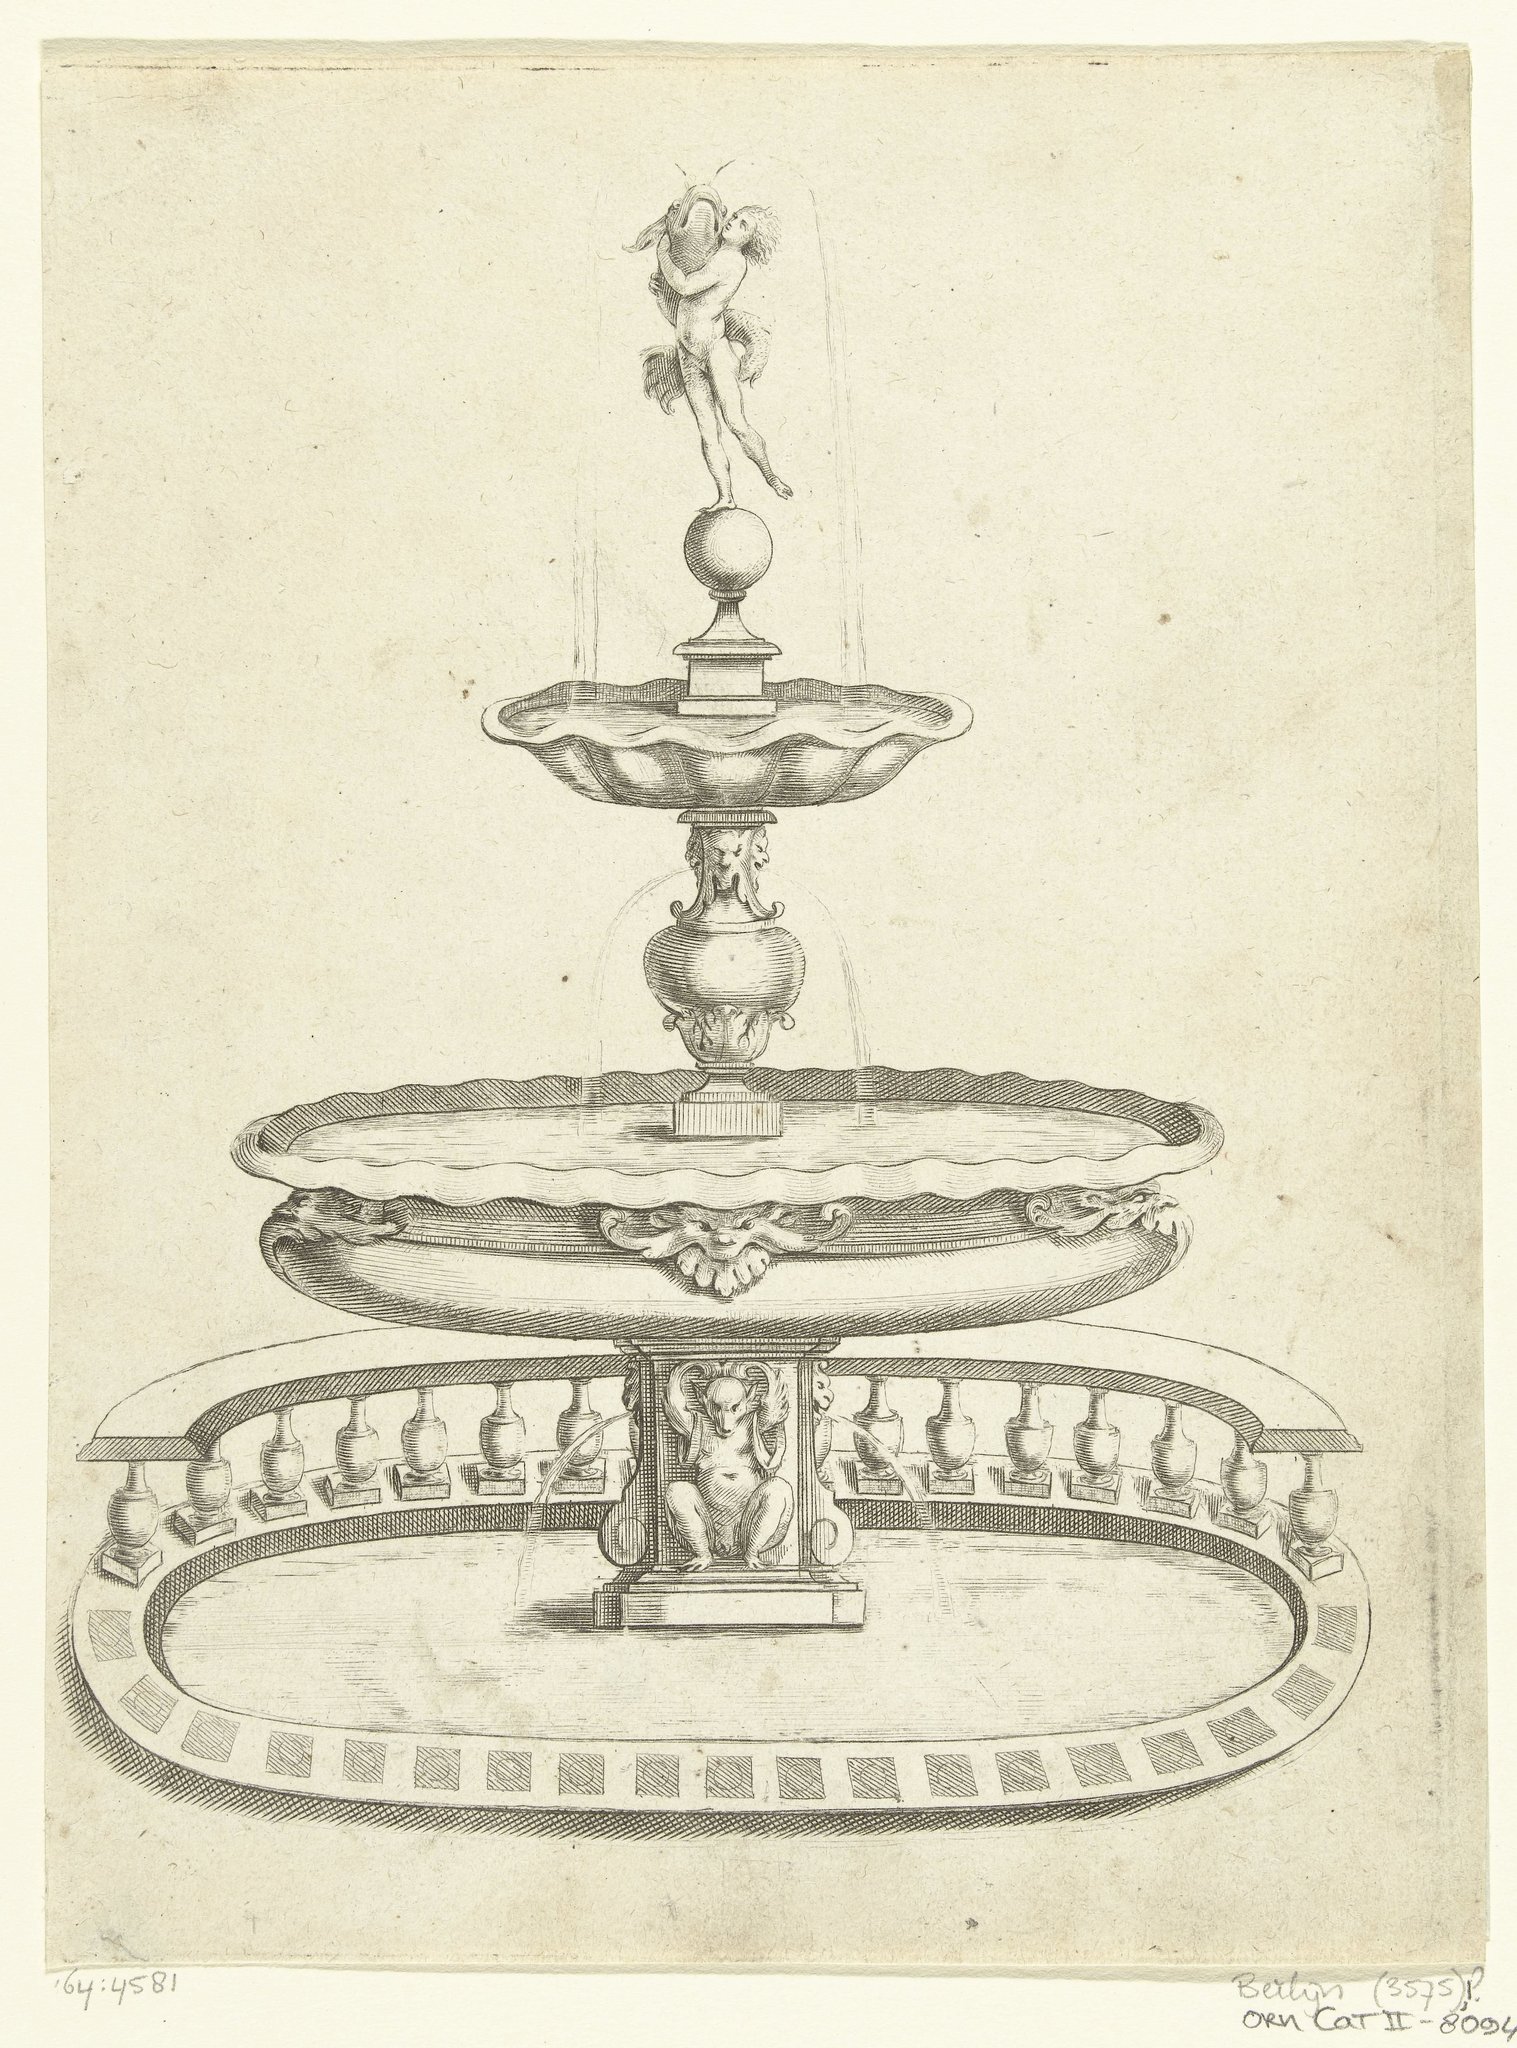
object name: print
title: Fontaines Et Iets D'Eau (...)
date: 1680-1707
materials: paper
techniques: engraving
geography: italy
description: Bovenop de fontein staat een jongen met een waterspuwende dolfijn in zijn armen. Uit serie van 16 bladen, tweede editie.